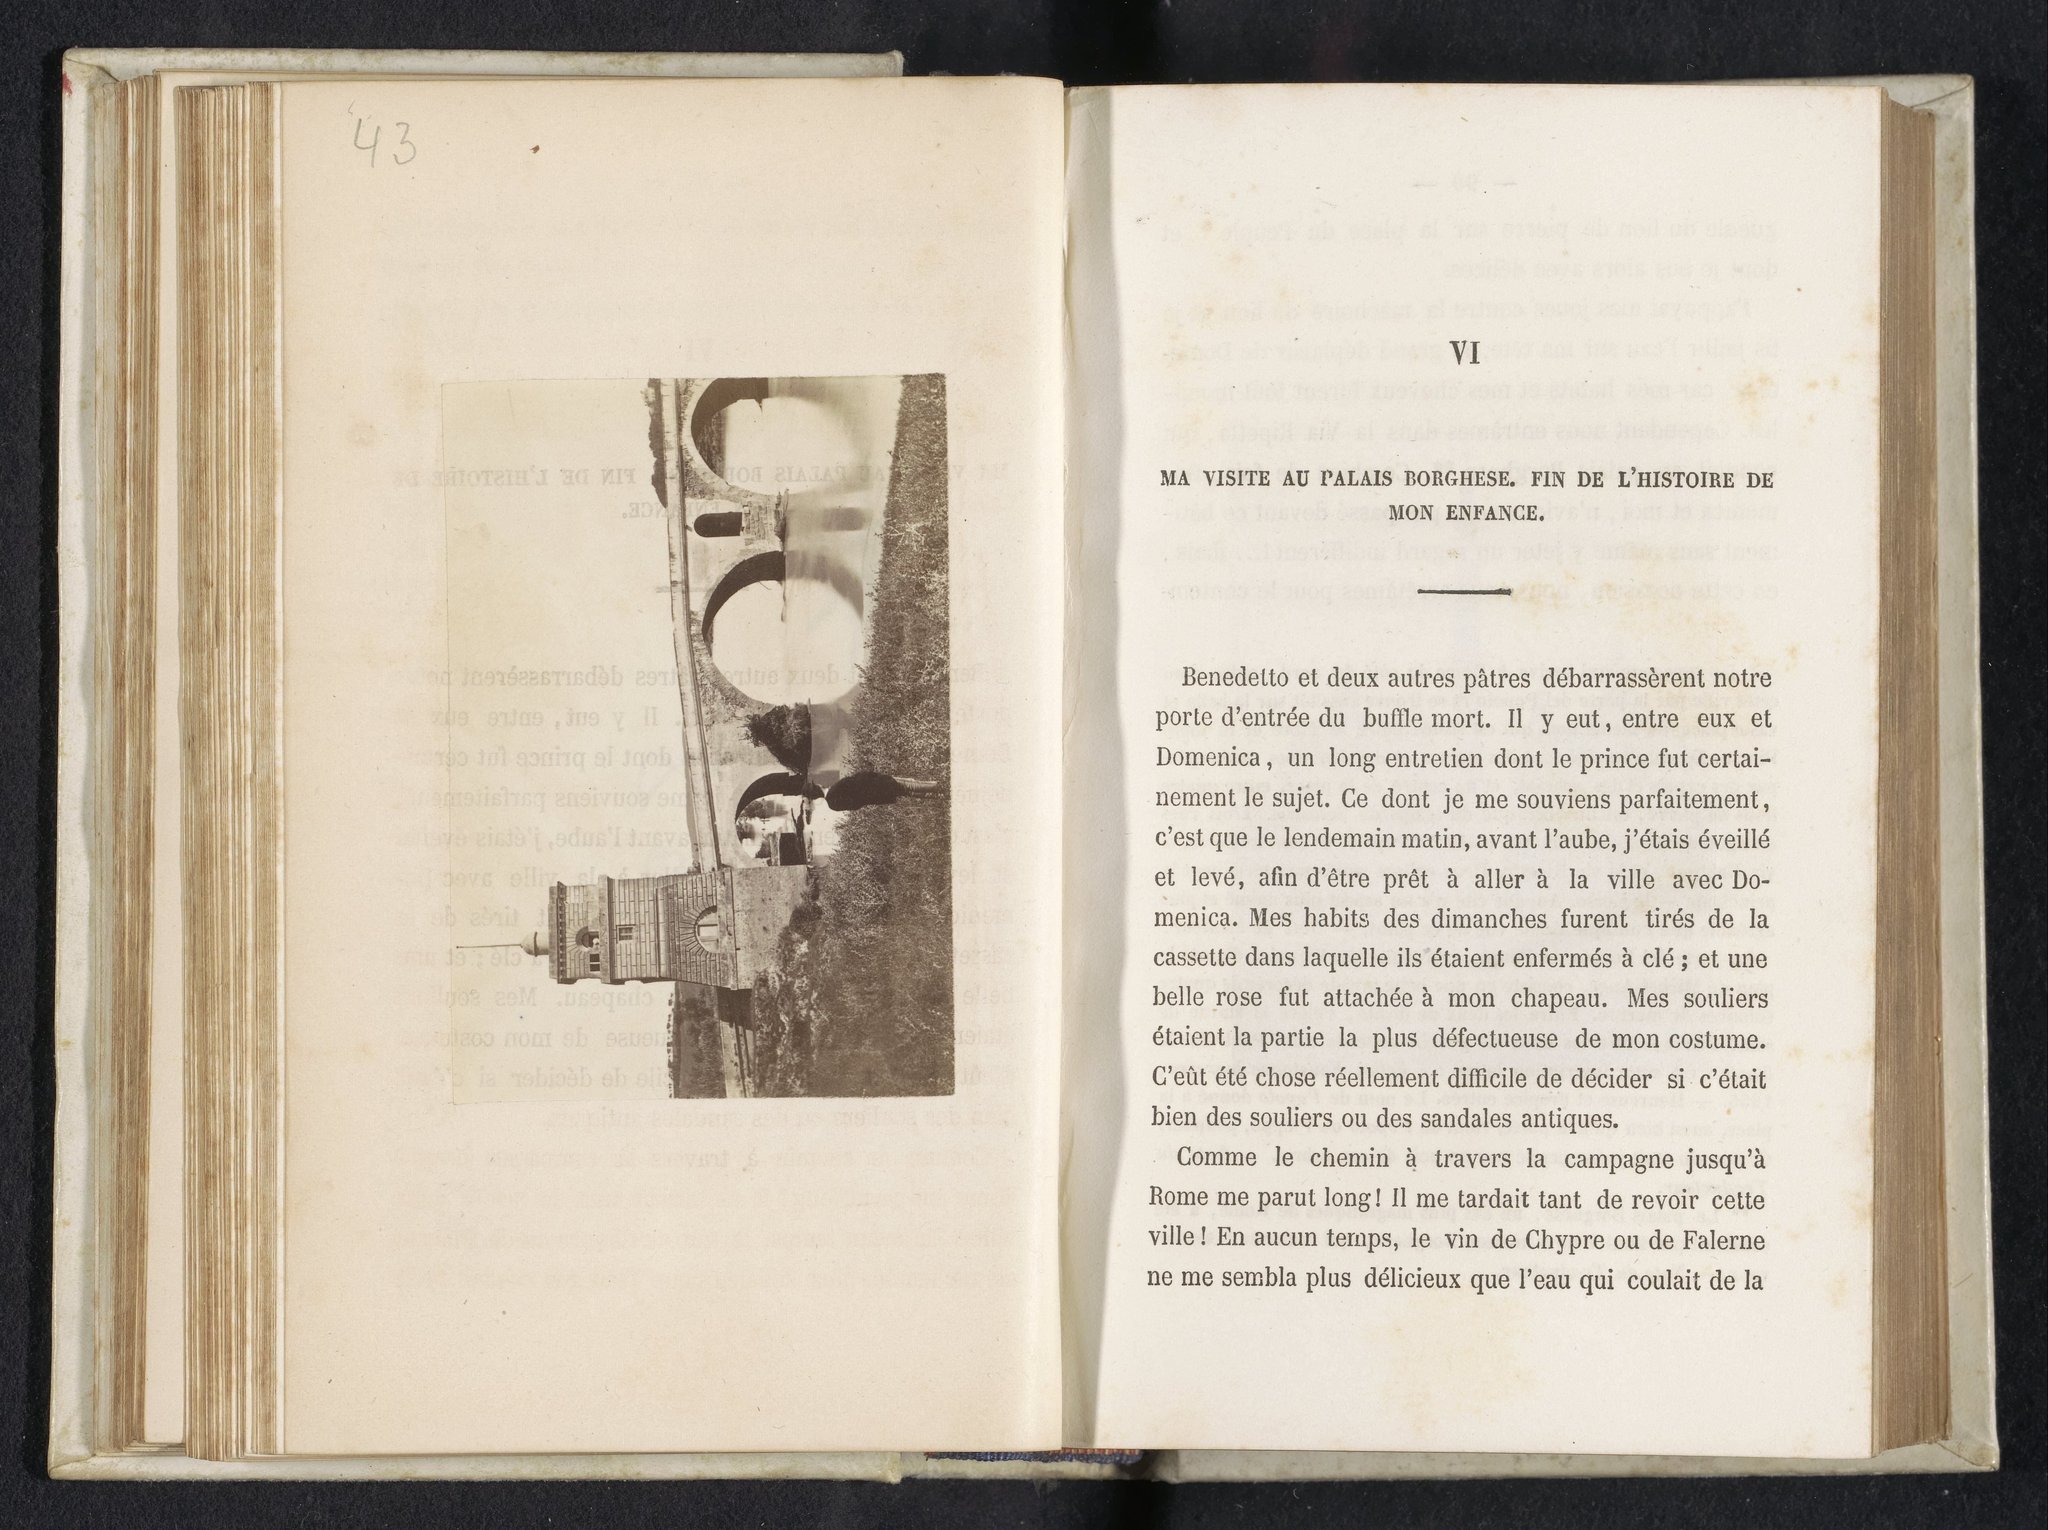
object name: photograph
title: Gezicht op een brug (vermoedelijk) te Rome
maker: Anonymous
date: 1850-1860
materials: photographic support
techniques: albumen print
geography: rome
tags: bridge